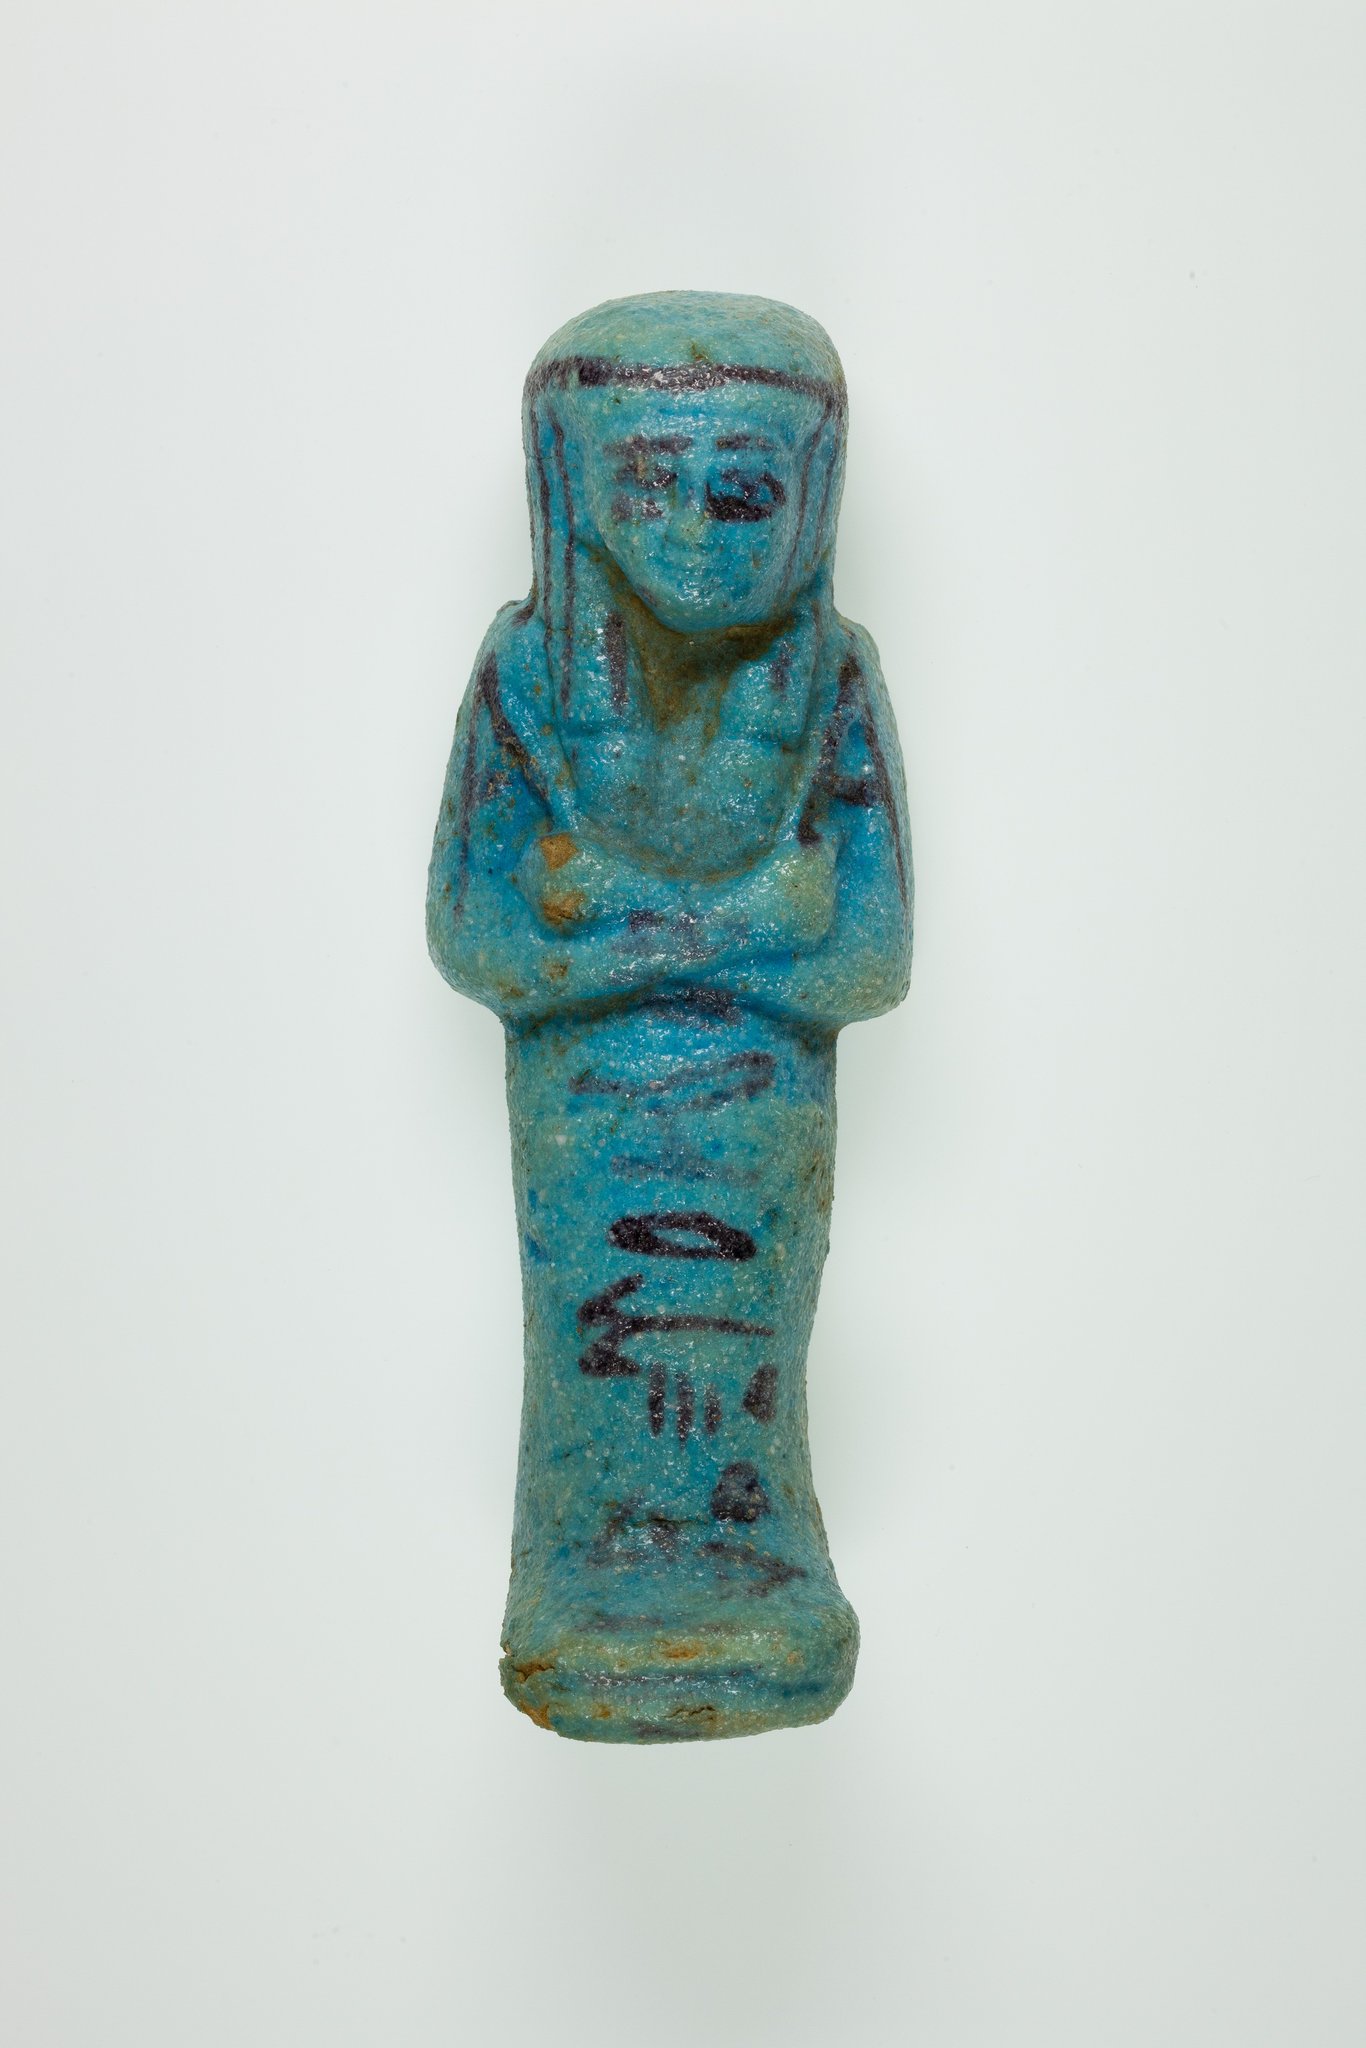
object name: worker shabti, henettawy c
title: Worker Shabti of Henettawy (C), Daughter of Isetemkheb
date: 990-970 BCE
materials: faience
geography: egypt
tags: hieroglyphs